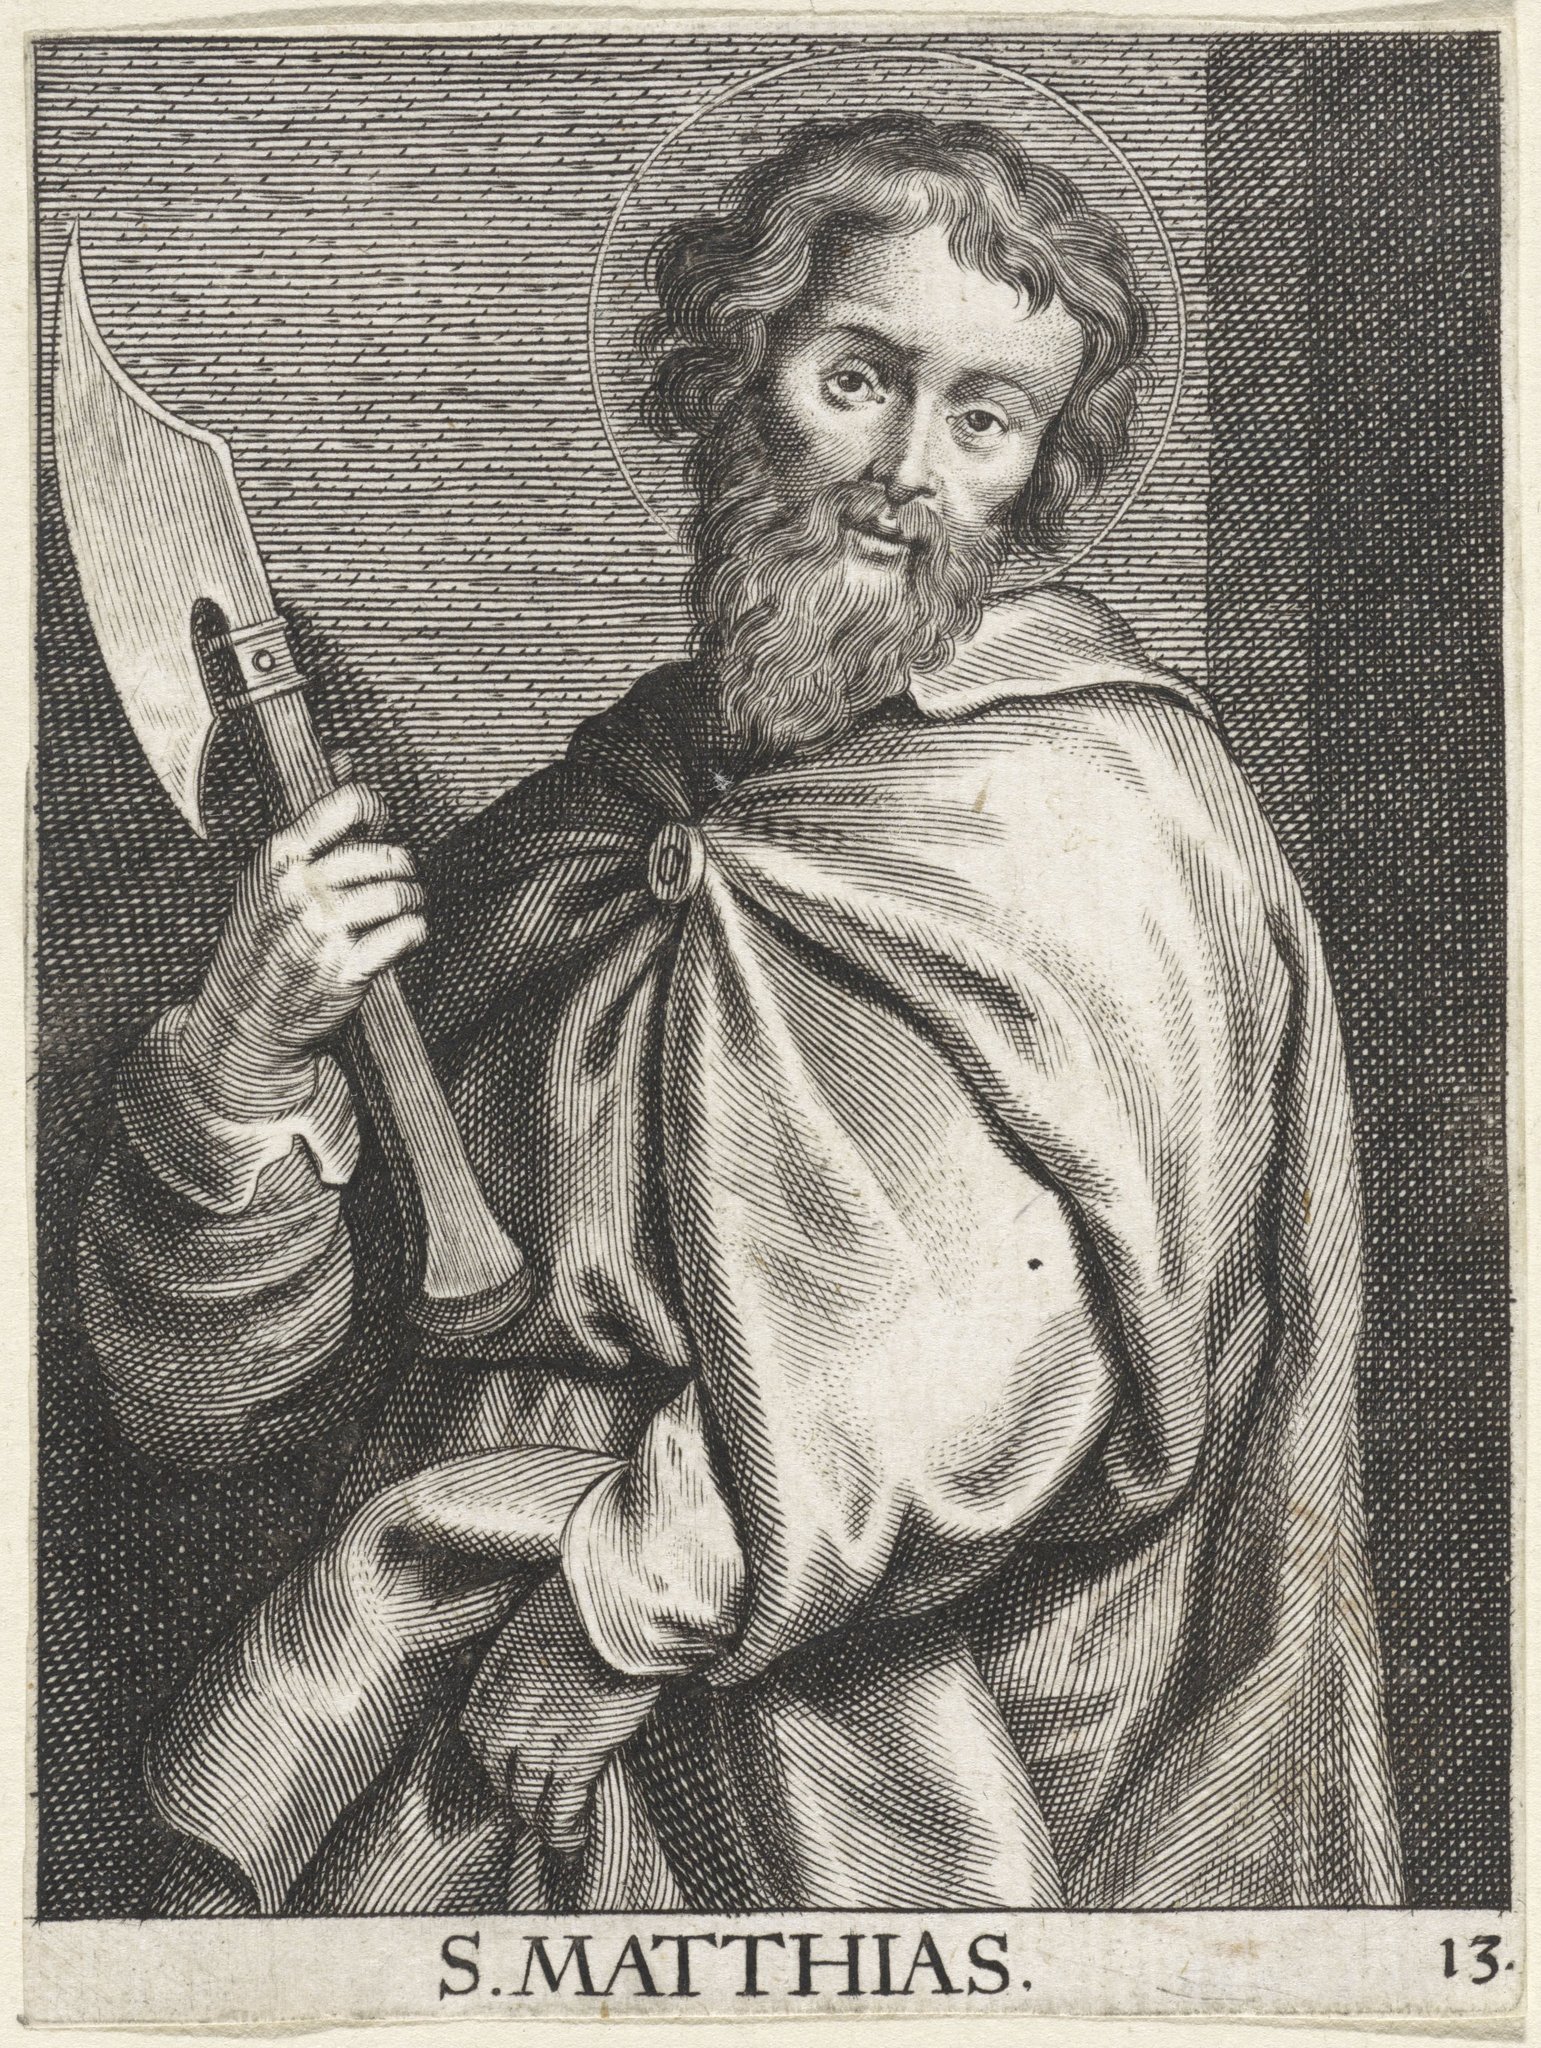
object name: print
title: S. Matthias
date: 1637-1666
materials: paper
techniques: engraving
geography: southern netherlands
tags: the apostle and martyr matthias; possible attributes: axe, book, cross, halberd, scroll, sword - portrait of male saint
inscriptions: collector's mark: Lugt 240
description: De apostel Mattias staat met een bijl voor een muur.